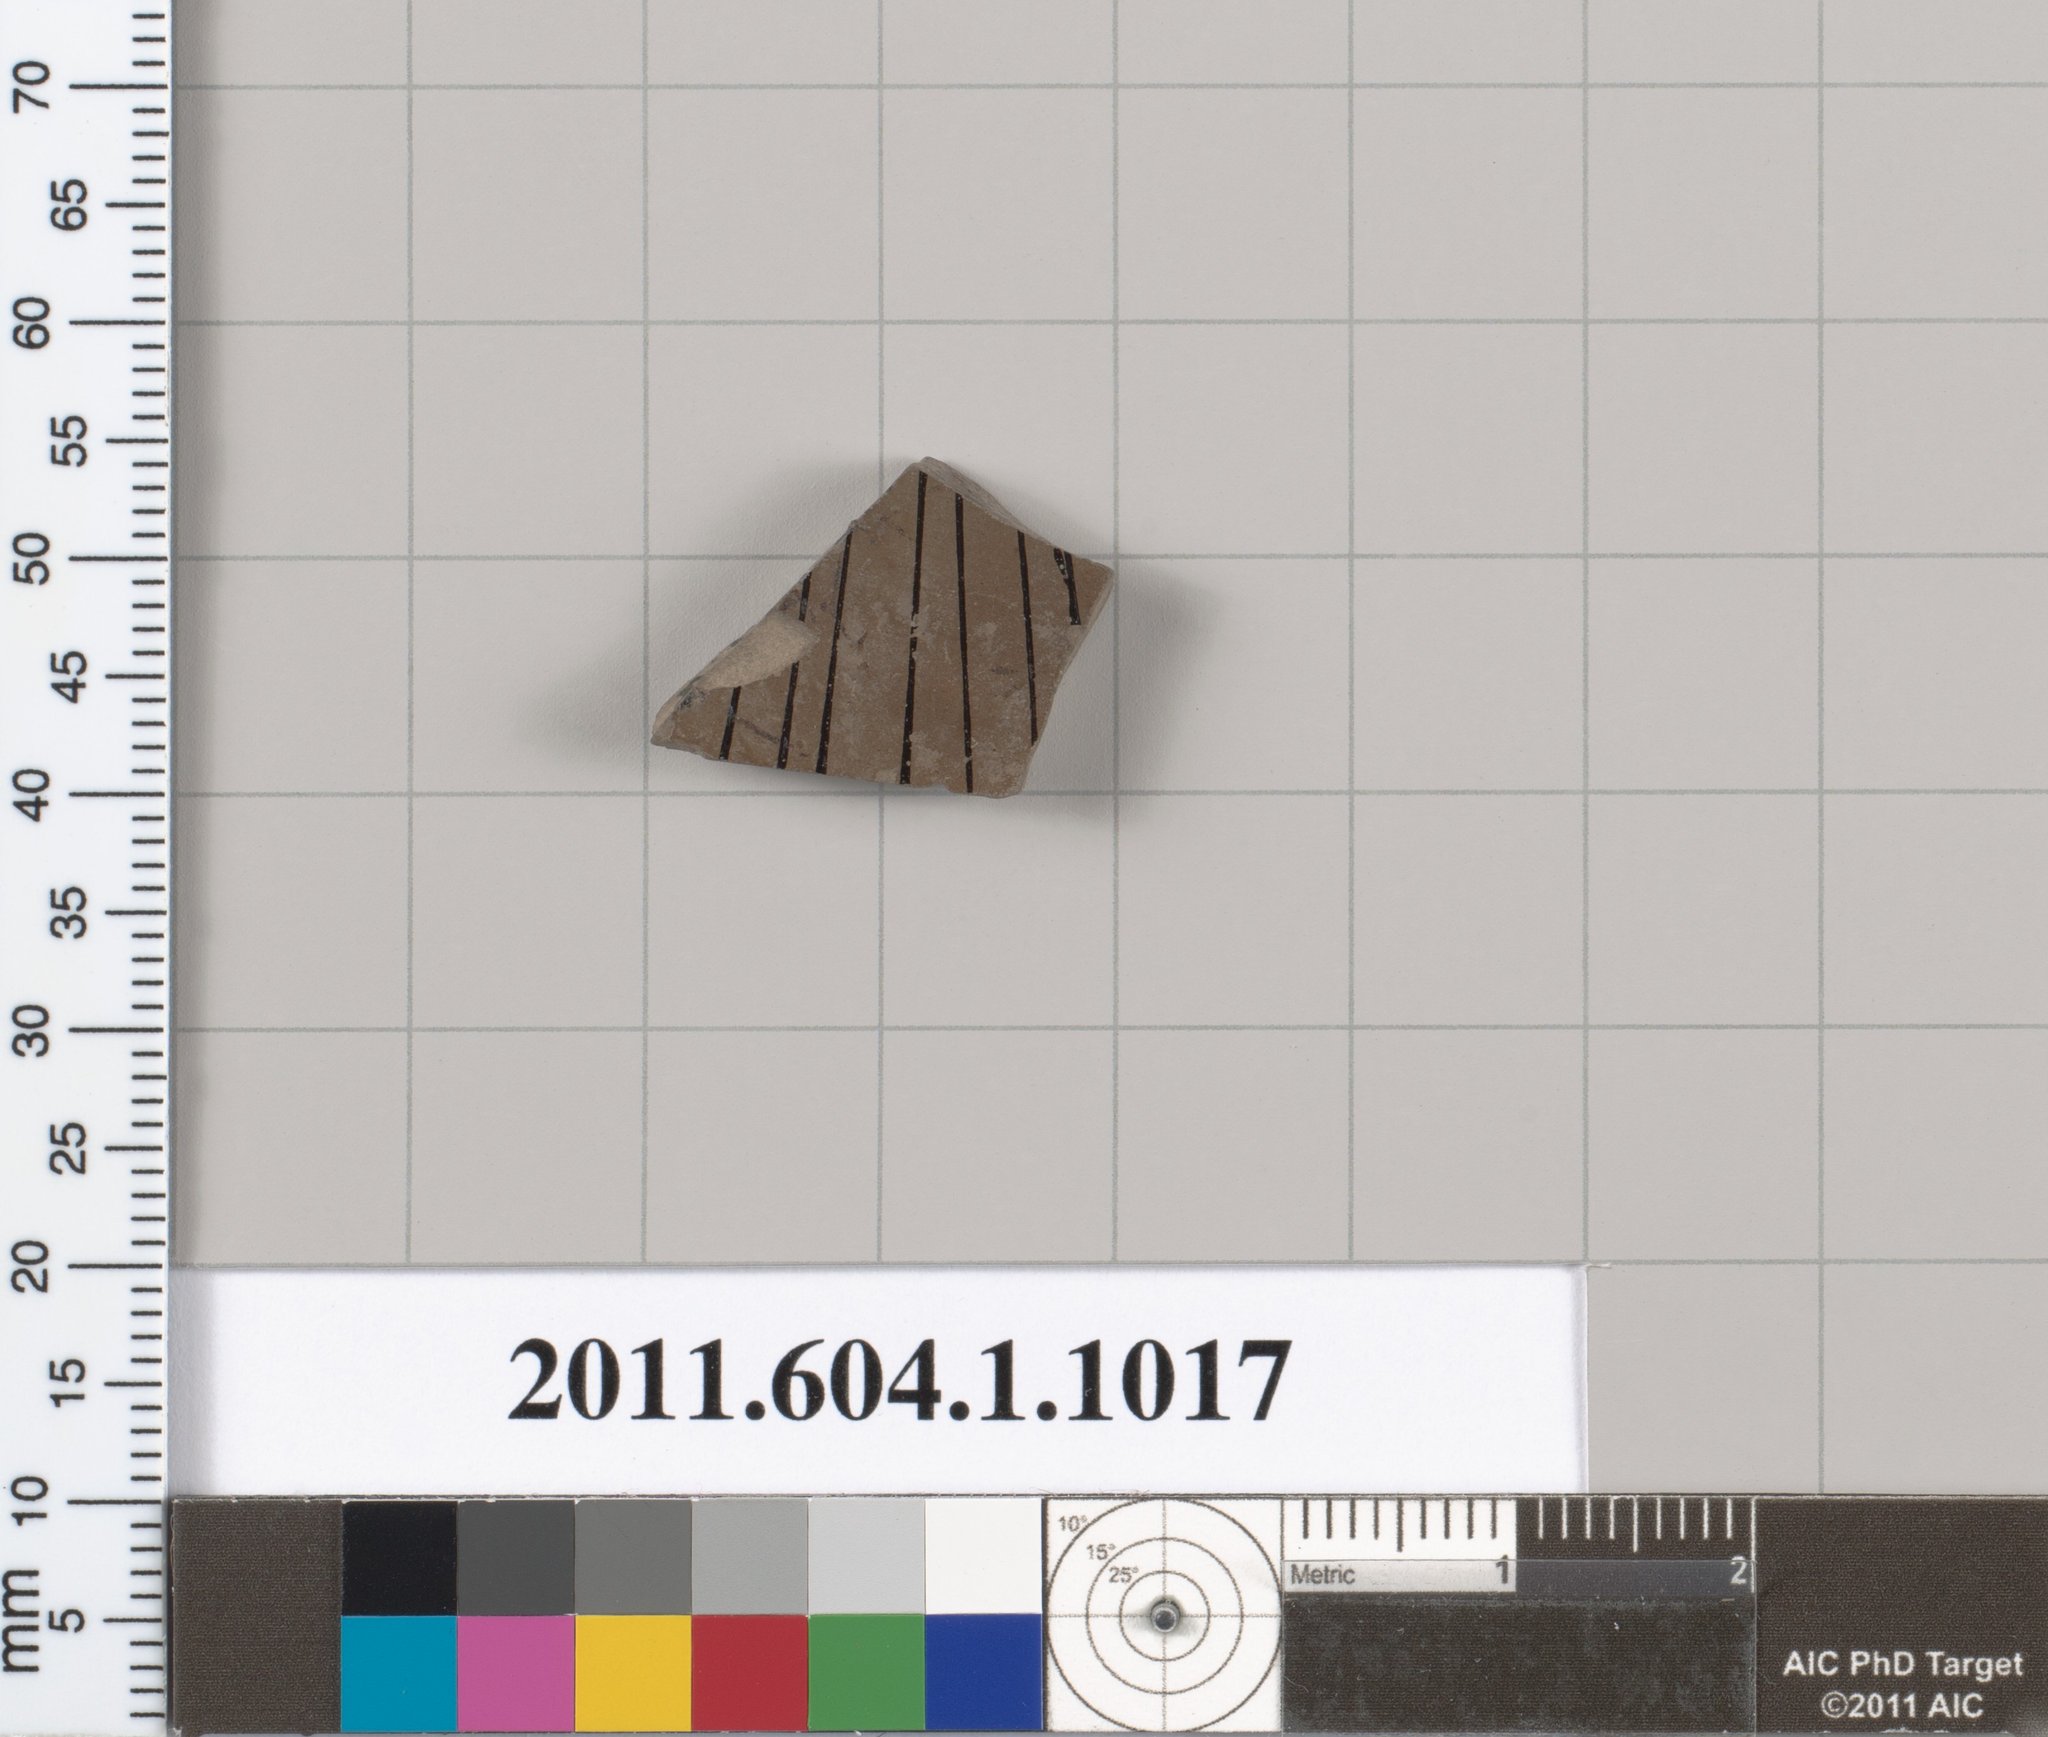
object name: kylix fragment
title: Terracotta fragment of a kylix (drinking cup)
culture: greek, attic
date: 475-451 BCE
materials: terracotta